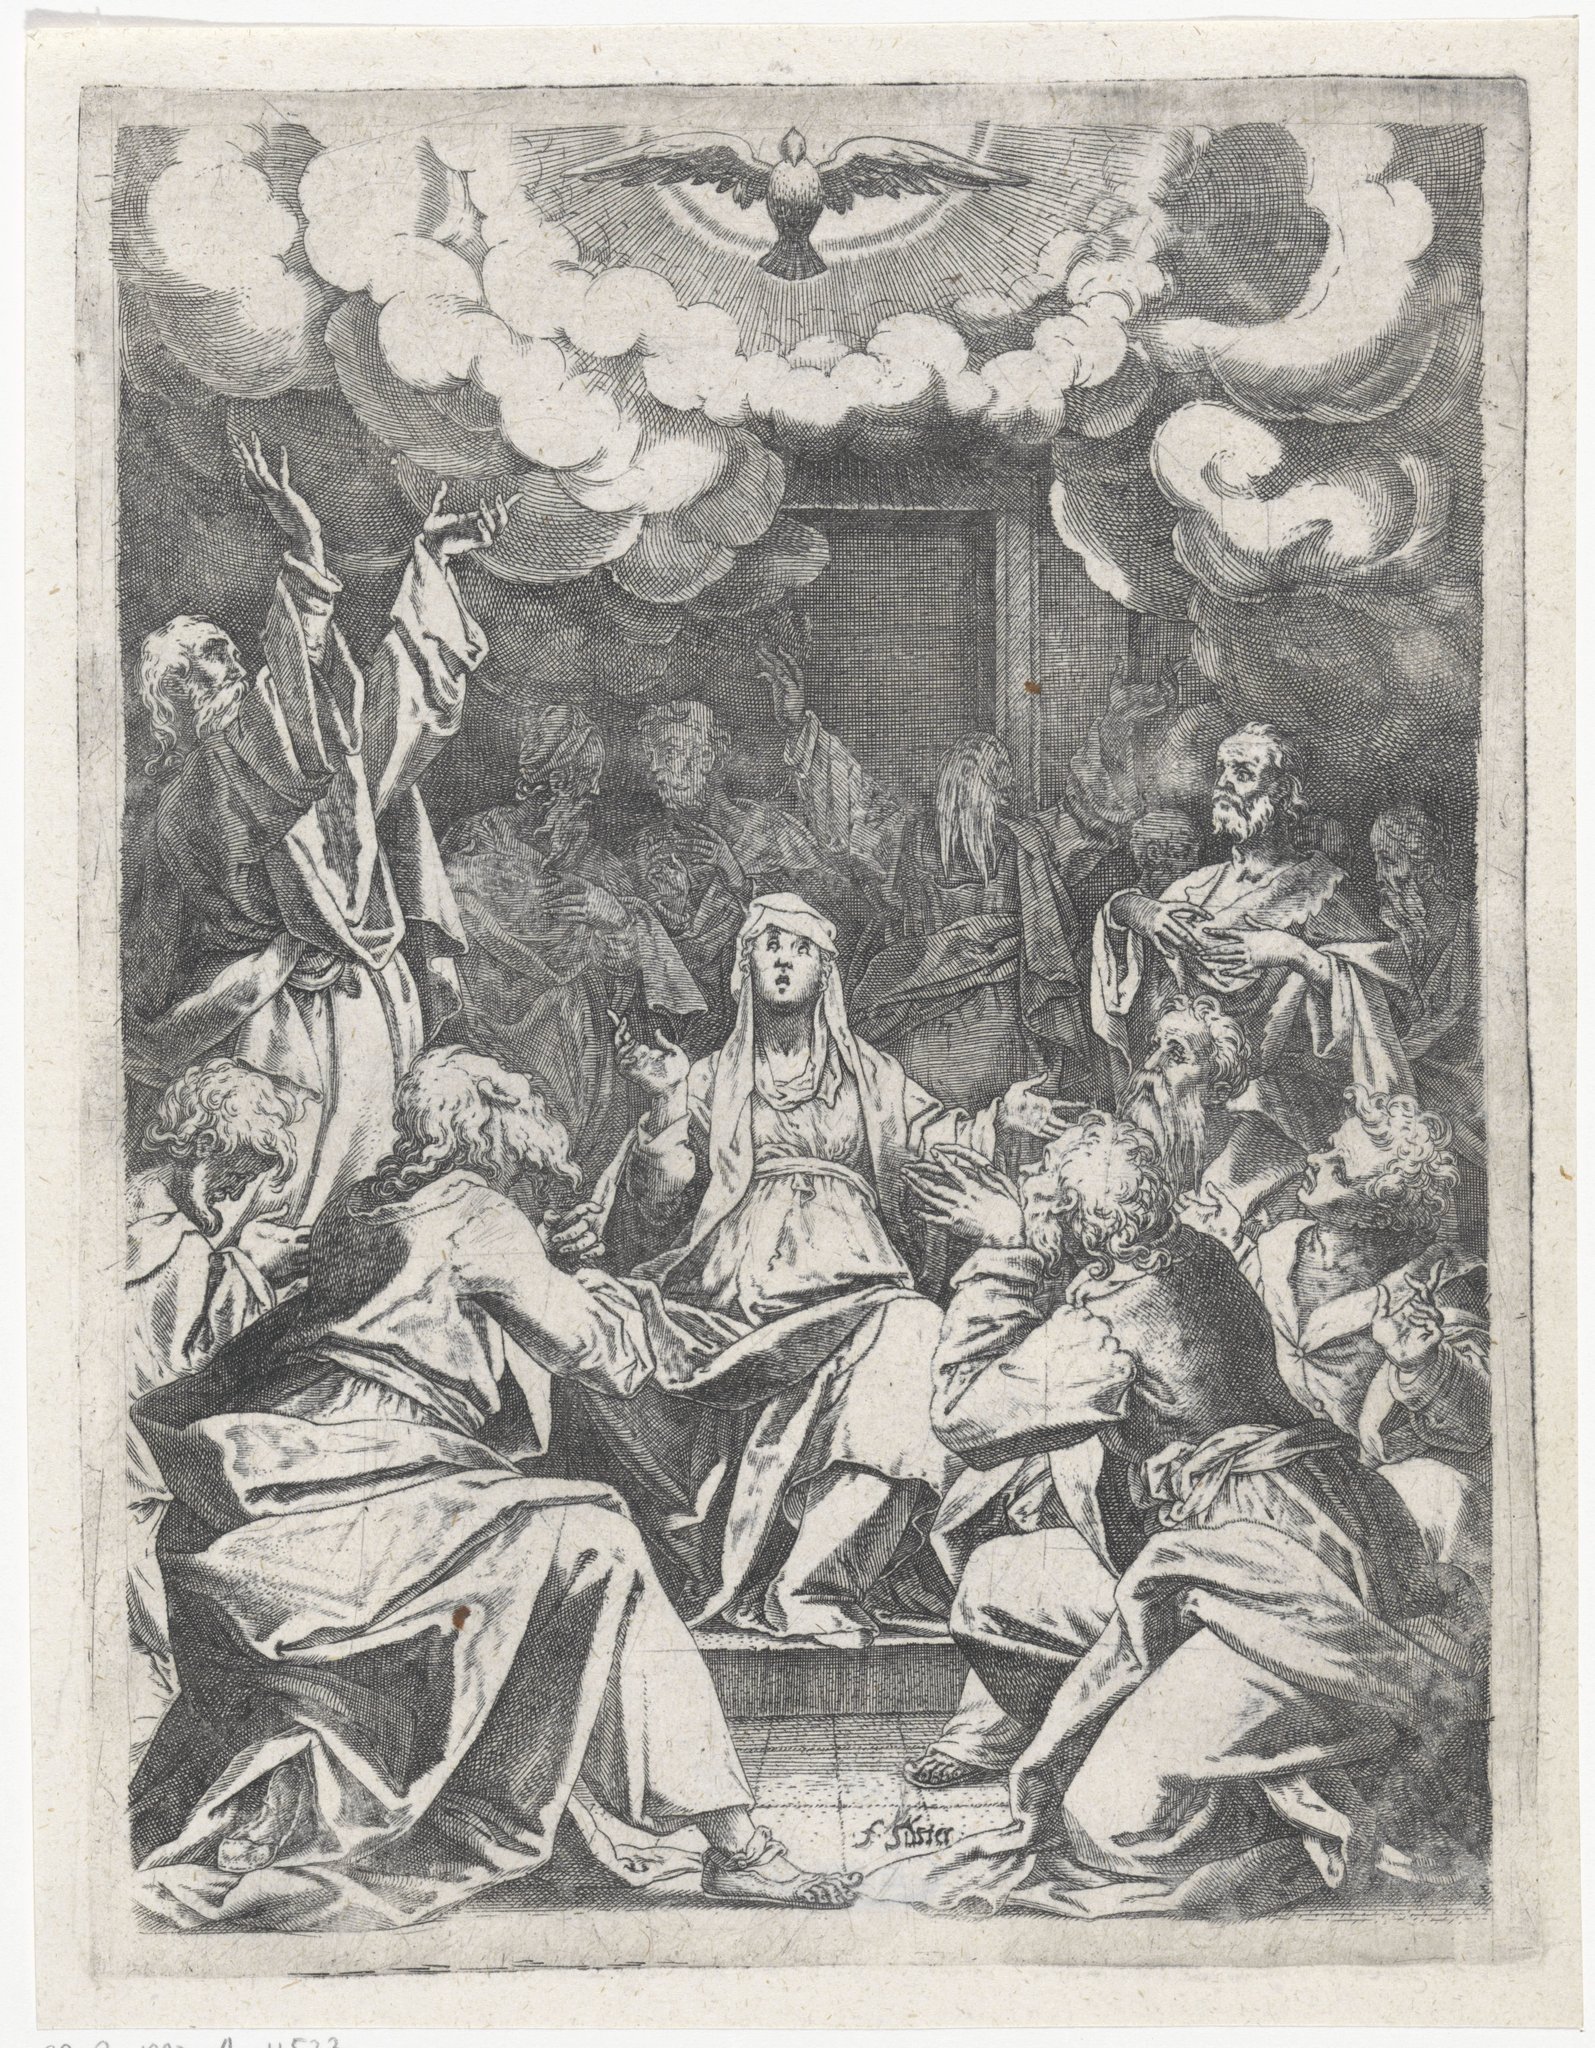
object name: print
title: Uitstorting van de Heilige Geest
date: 1560-1599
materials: paper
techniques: engraving, etching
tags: pentecost: the holy ghost descends upon (mary and) the apostles, sometimes paul and/or representatives of the nations present (acts 2:1-4)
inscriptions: collector's mark: Lugt 2228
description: De Heilige Geest in de gedaante van een duif daalt neer op Maria en de apostelen.